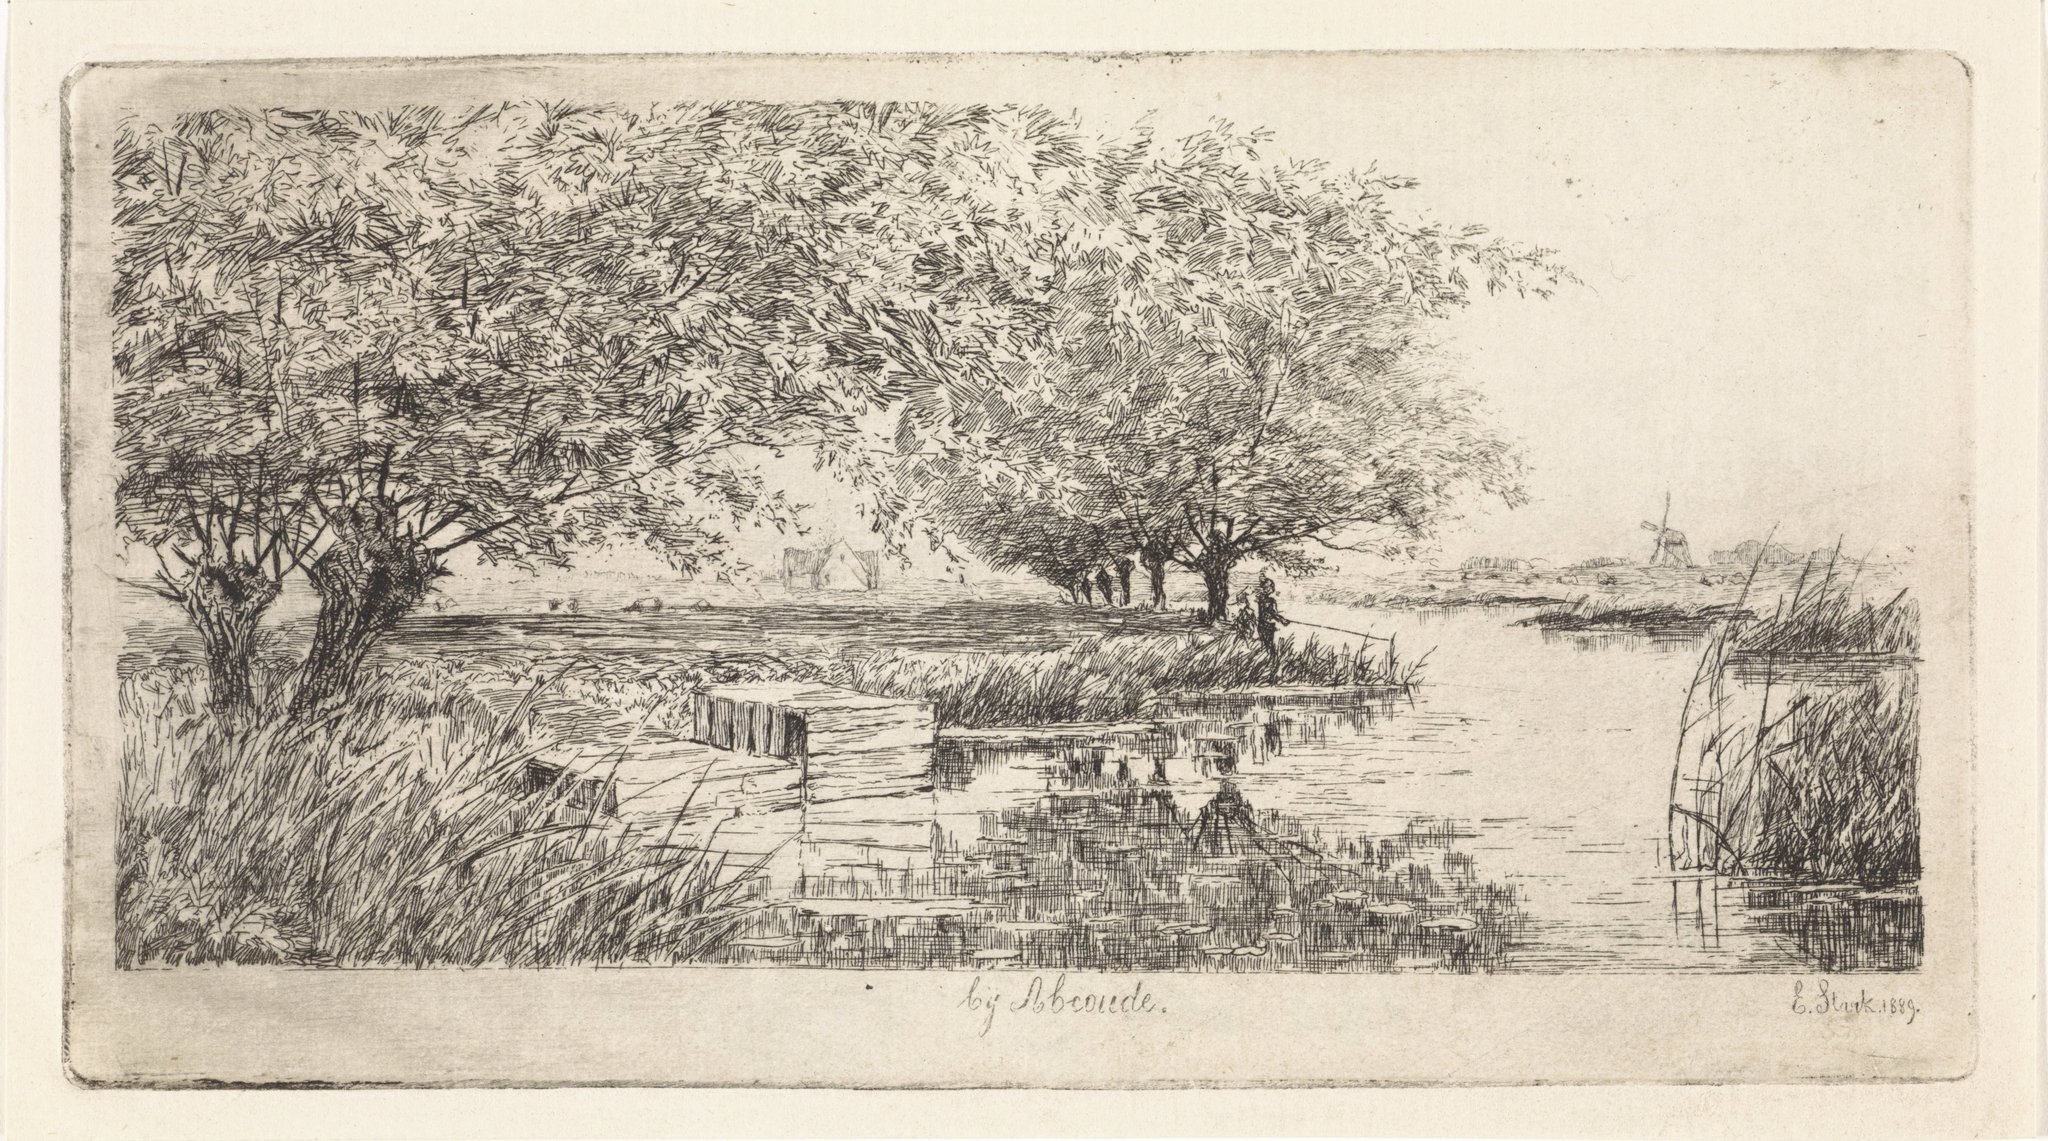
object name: print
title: Wetering bij Abcoude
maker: elias stark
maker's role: draughtsman, print maker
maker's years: 1849-1933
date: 1889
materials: paper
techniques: etching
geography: nieuwer-amstel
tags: water course, abcoude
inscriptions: collector's mark: Lugt 2228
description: Een wetering met knotwilgen langs de kant bij Abcoude. Rechts aan de horizon een molen.